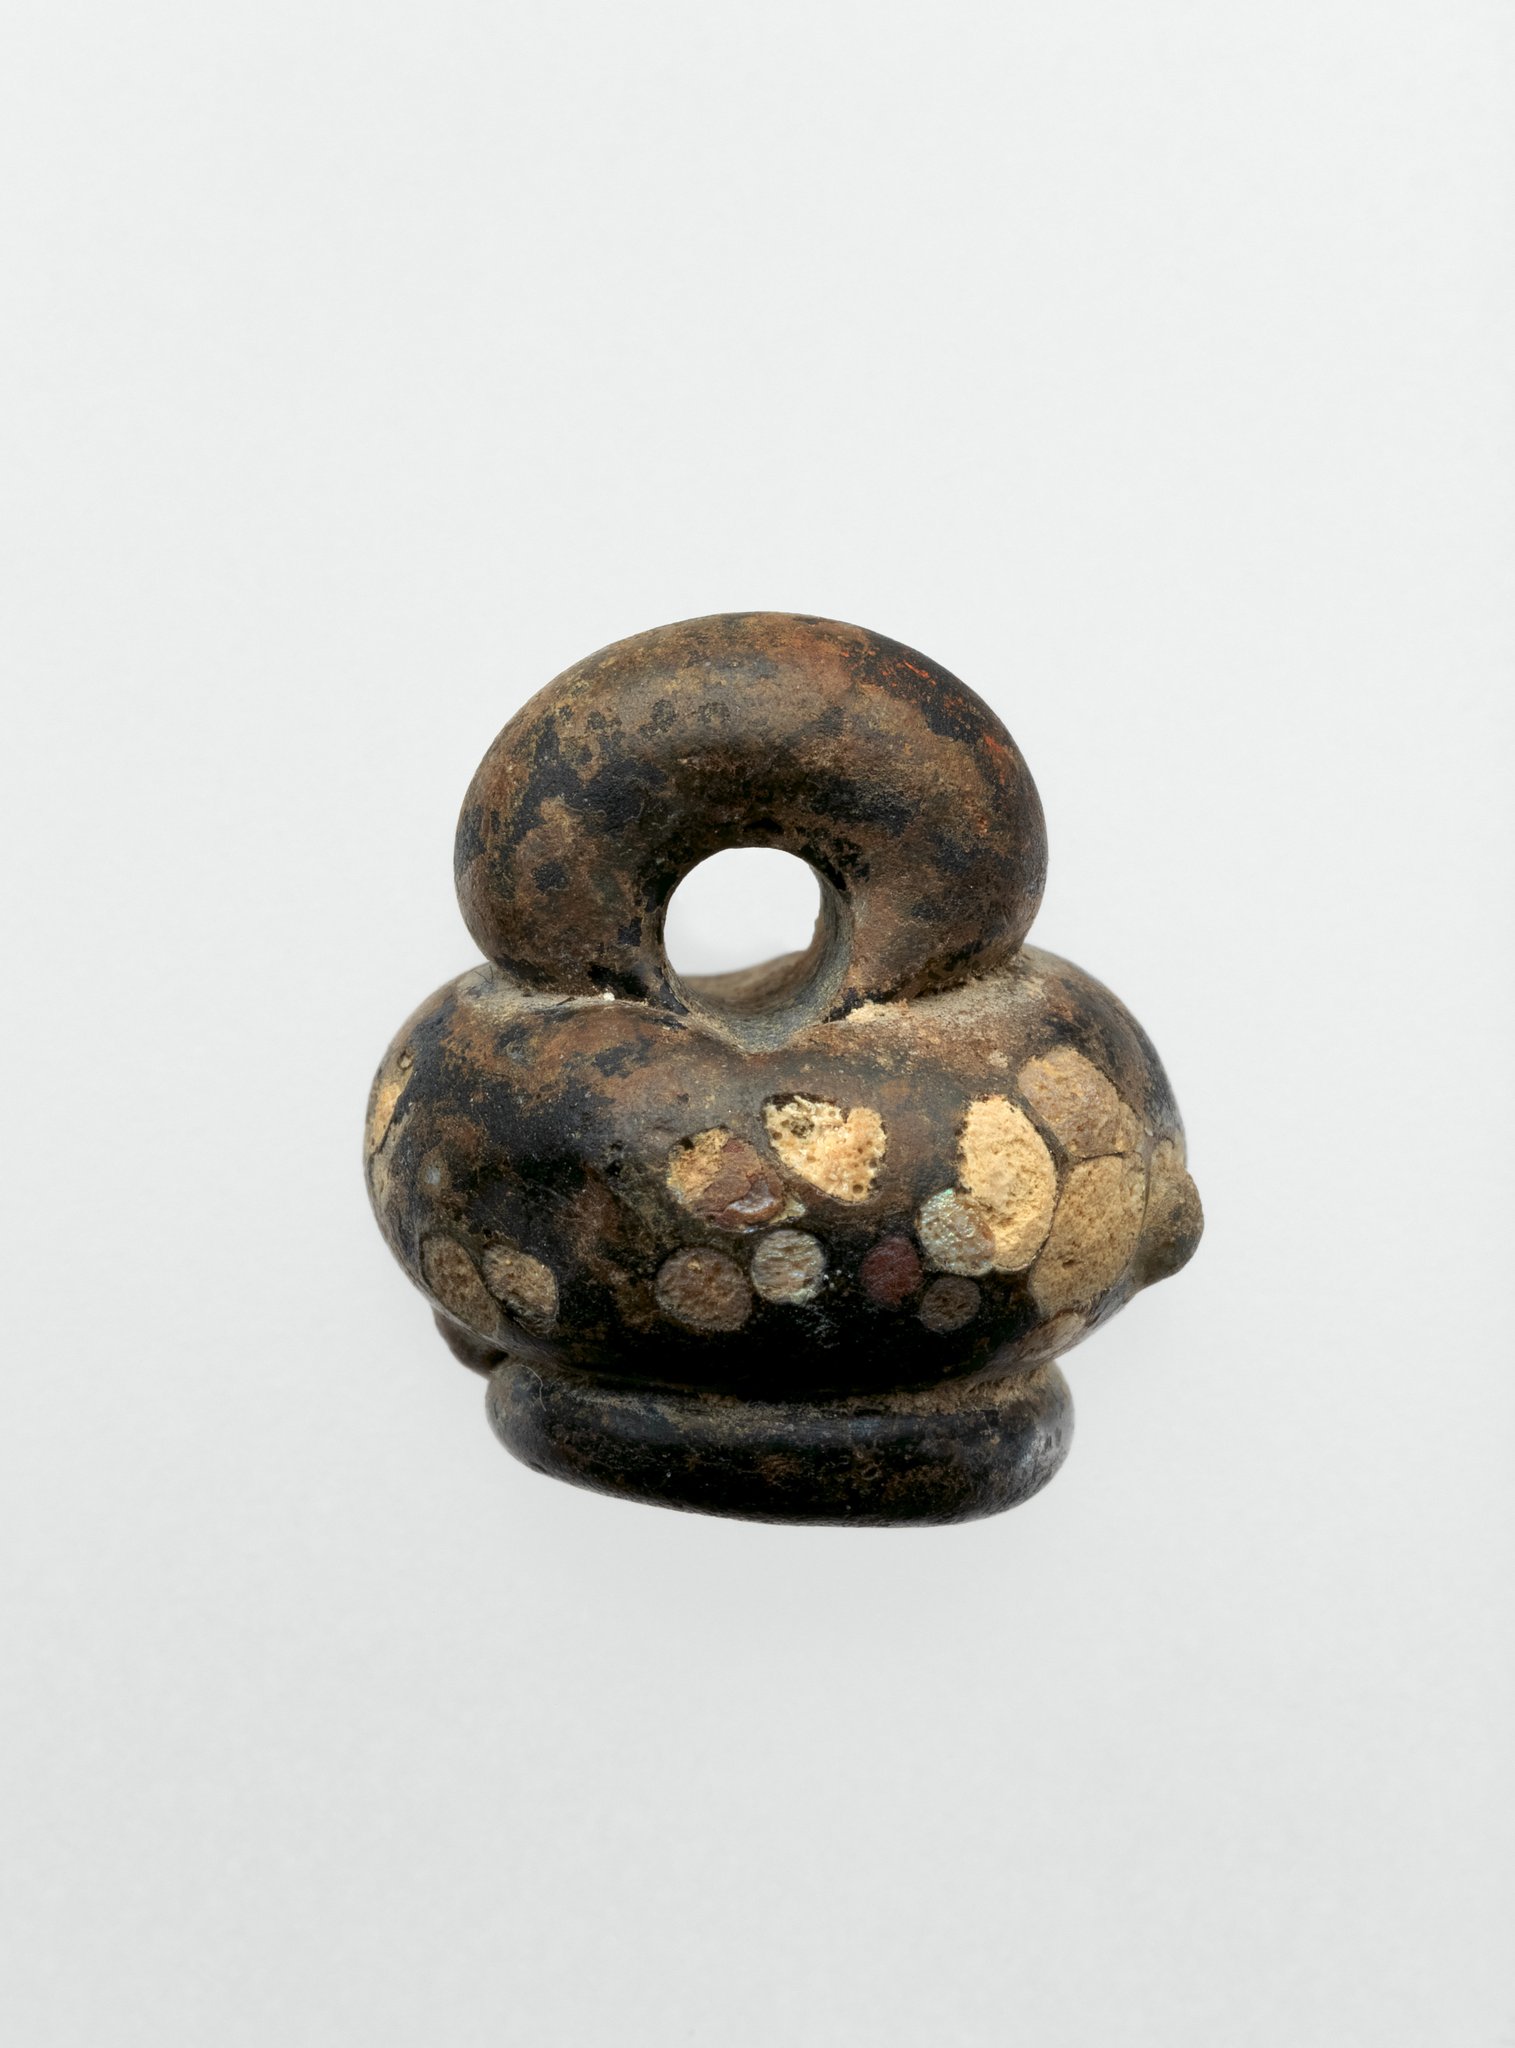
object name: pendant in the form of a jar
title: Glass pendant in the form of a miniature jar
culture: roman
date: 267-400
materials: glass